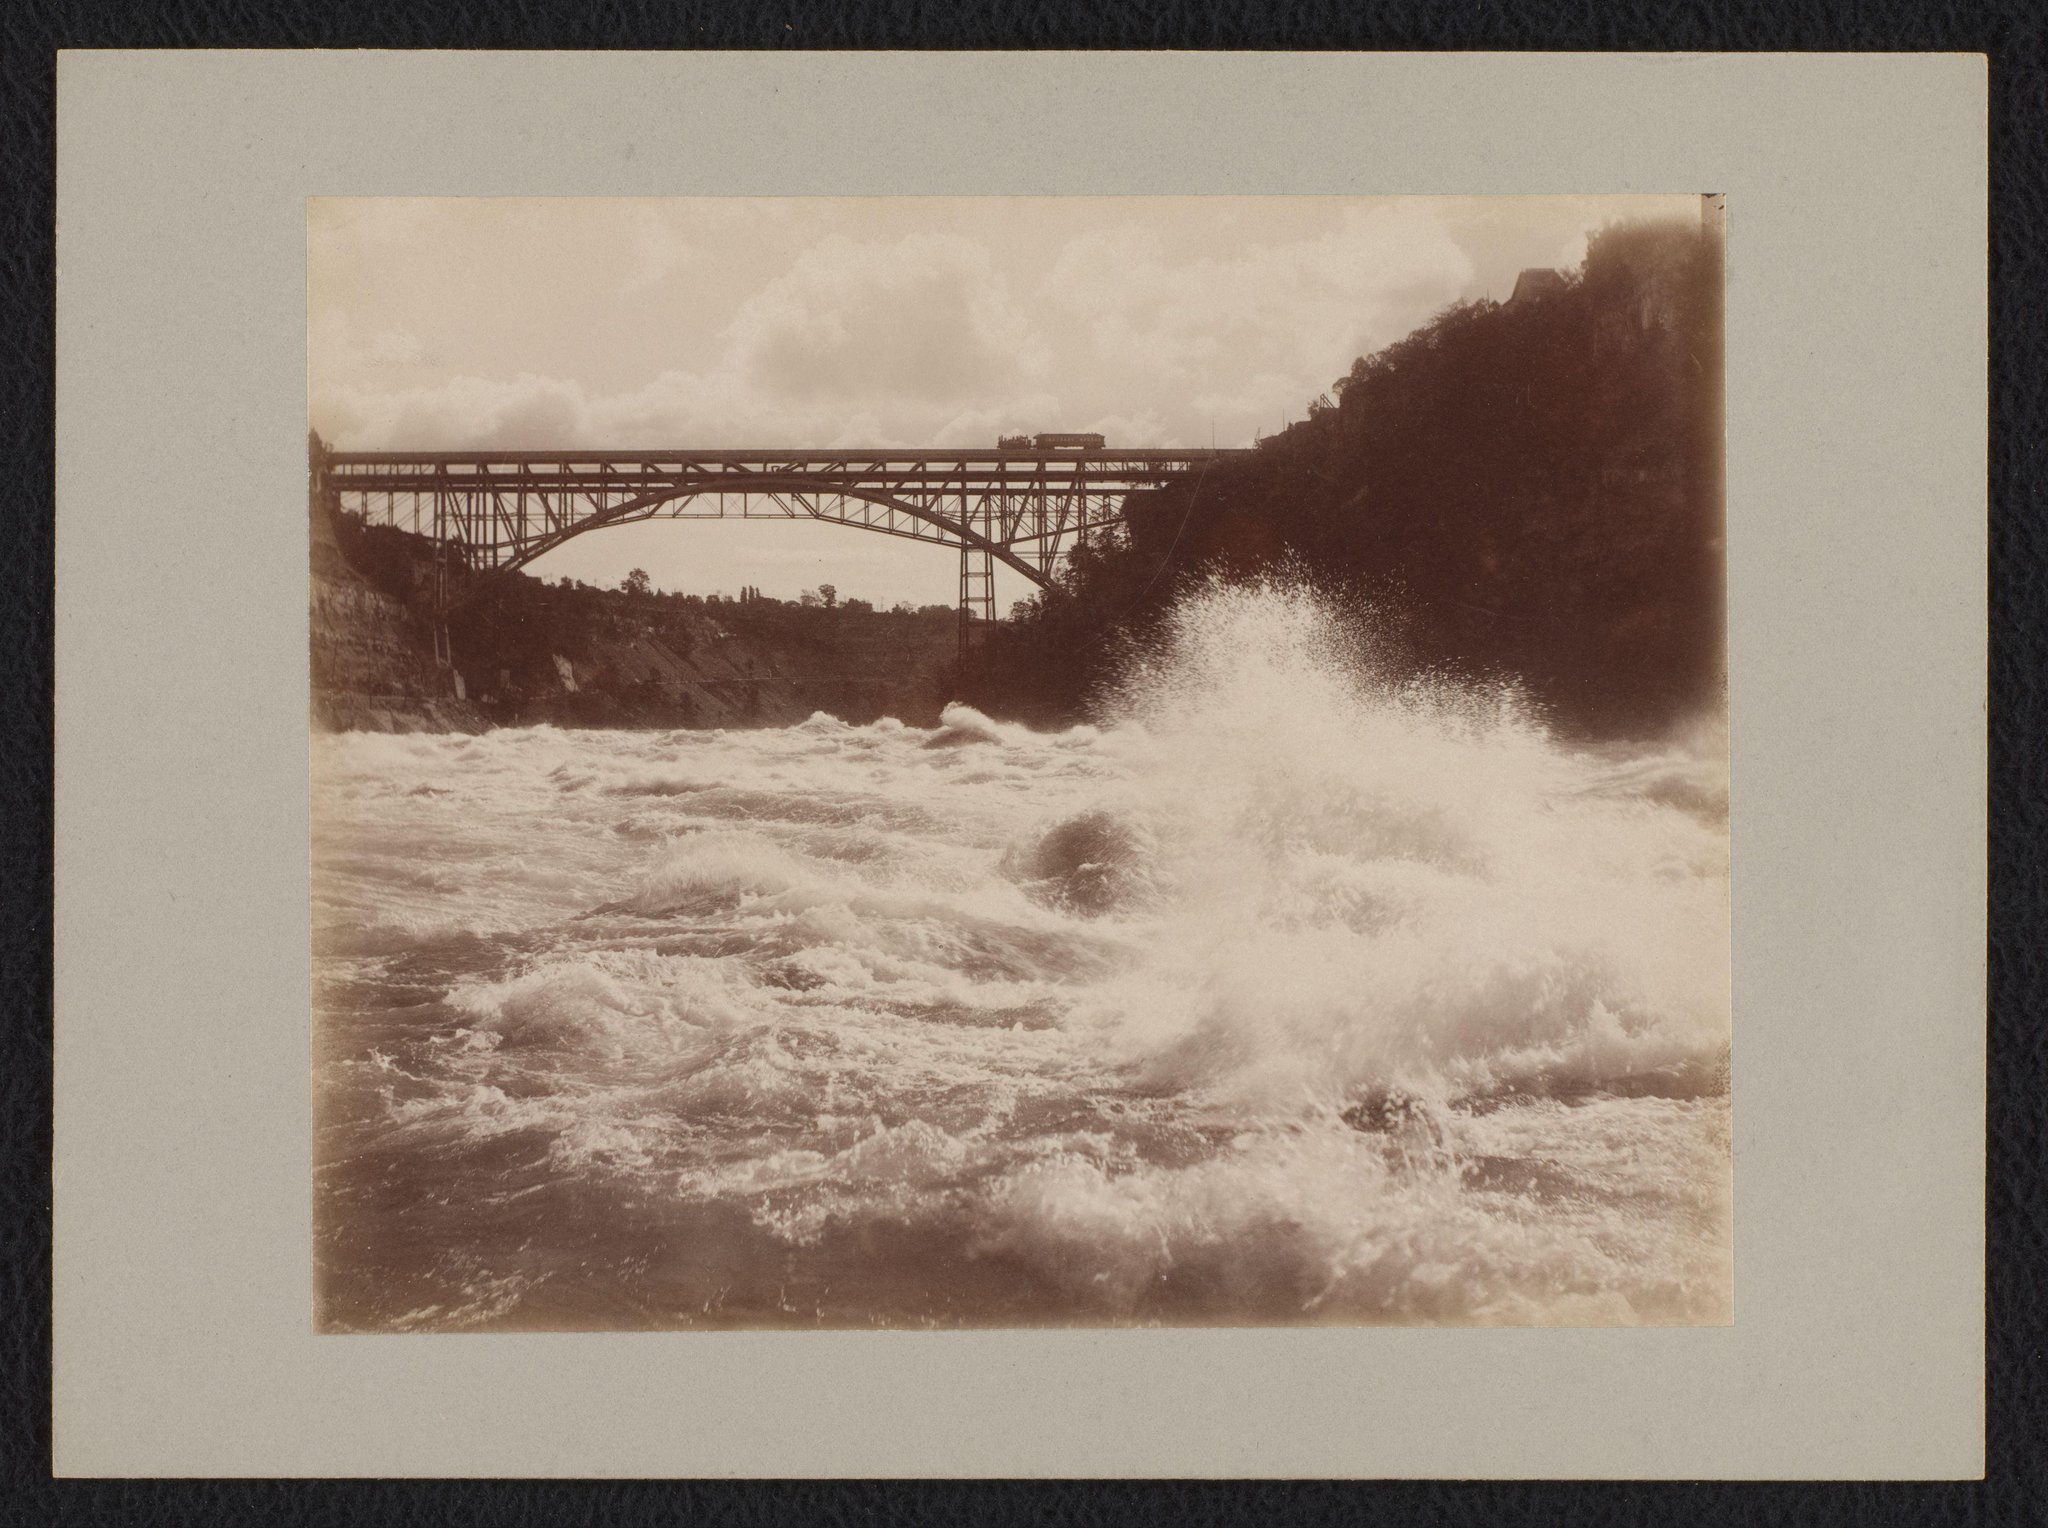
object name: photograph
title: Brug tussen Amerika en Canada, Verenigde Staten/Canada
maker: Anonymous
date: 1895-1915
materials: cardboard, photographic support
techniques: albumen print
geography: niagara falls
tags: niagara falls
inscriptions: annotation: ‘10. Brug tusschen Canada & Amerika’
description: Brug tussen Amerika en Canada vanaf het water gezien.